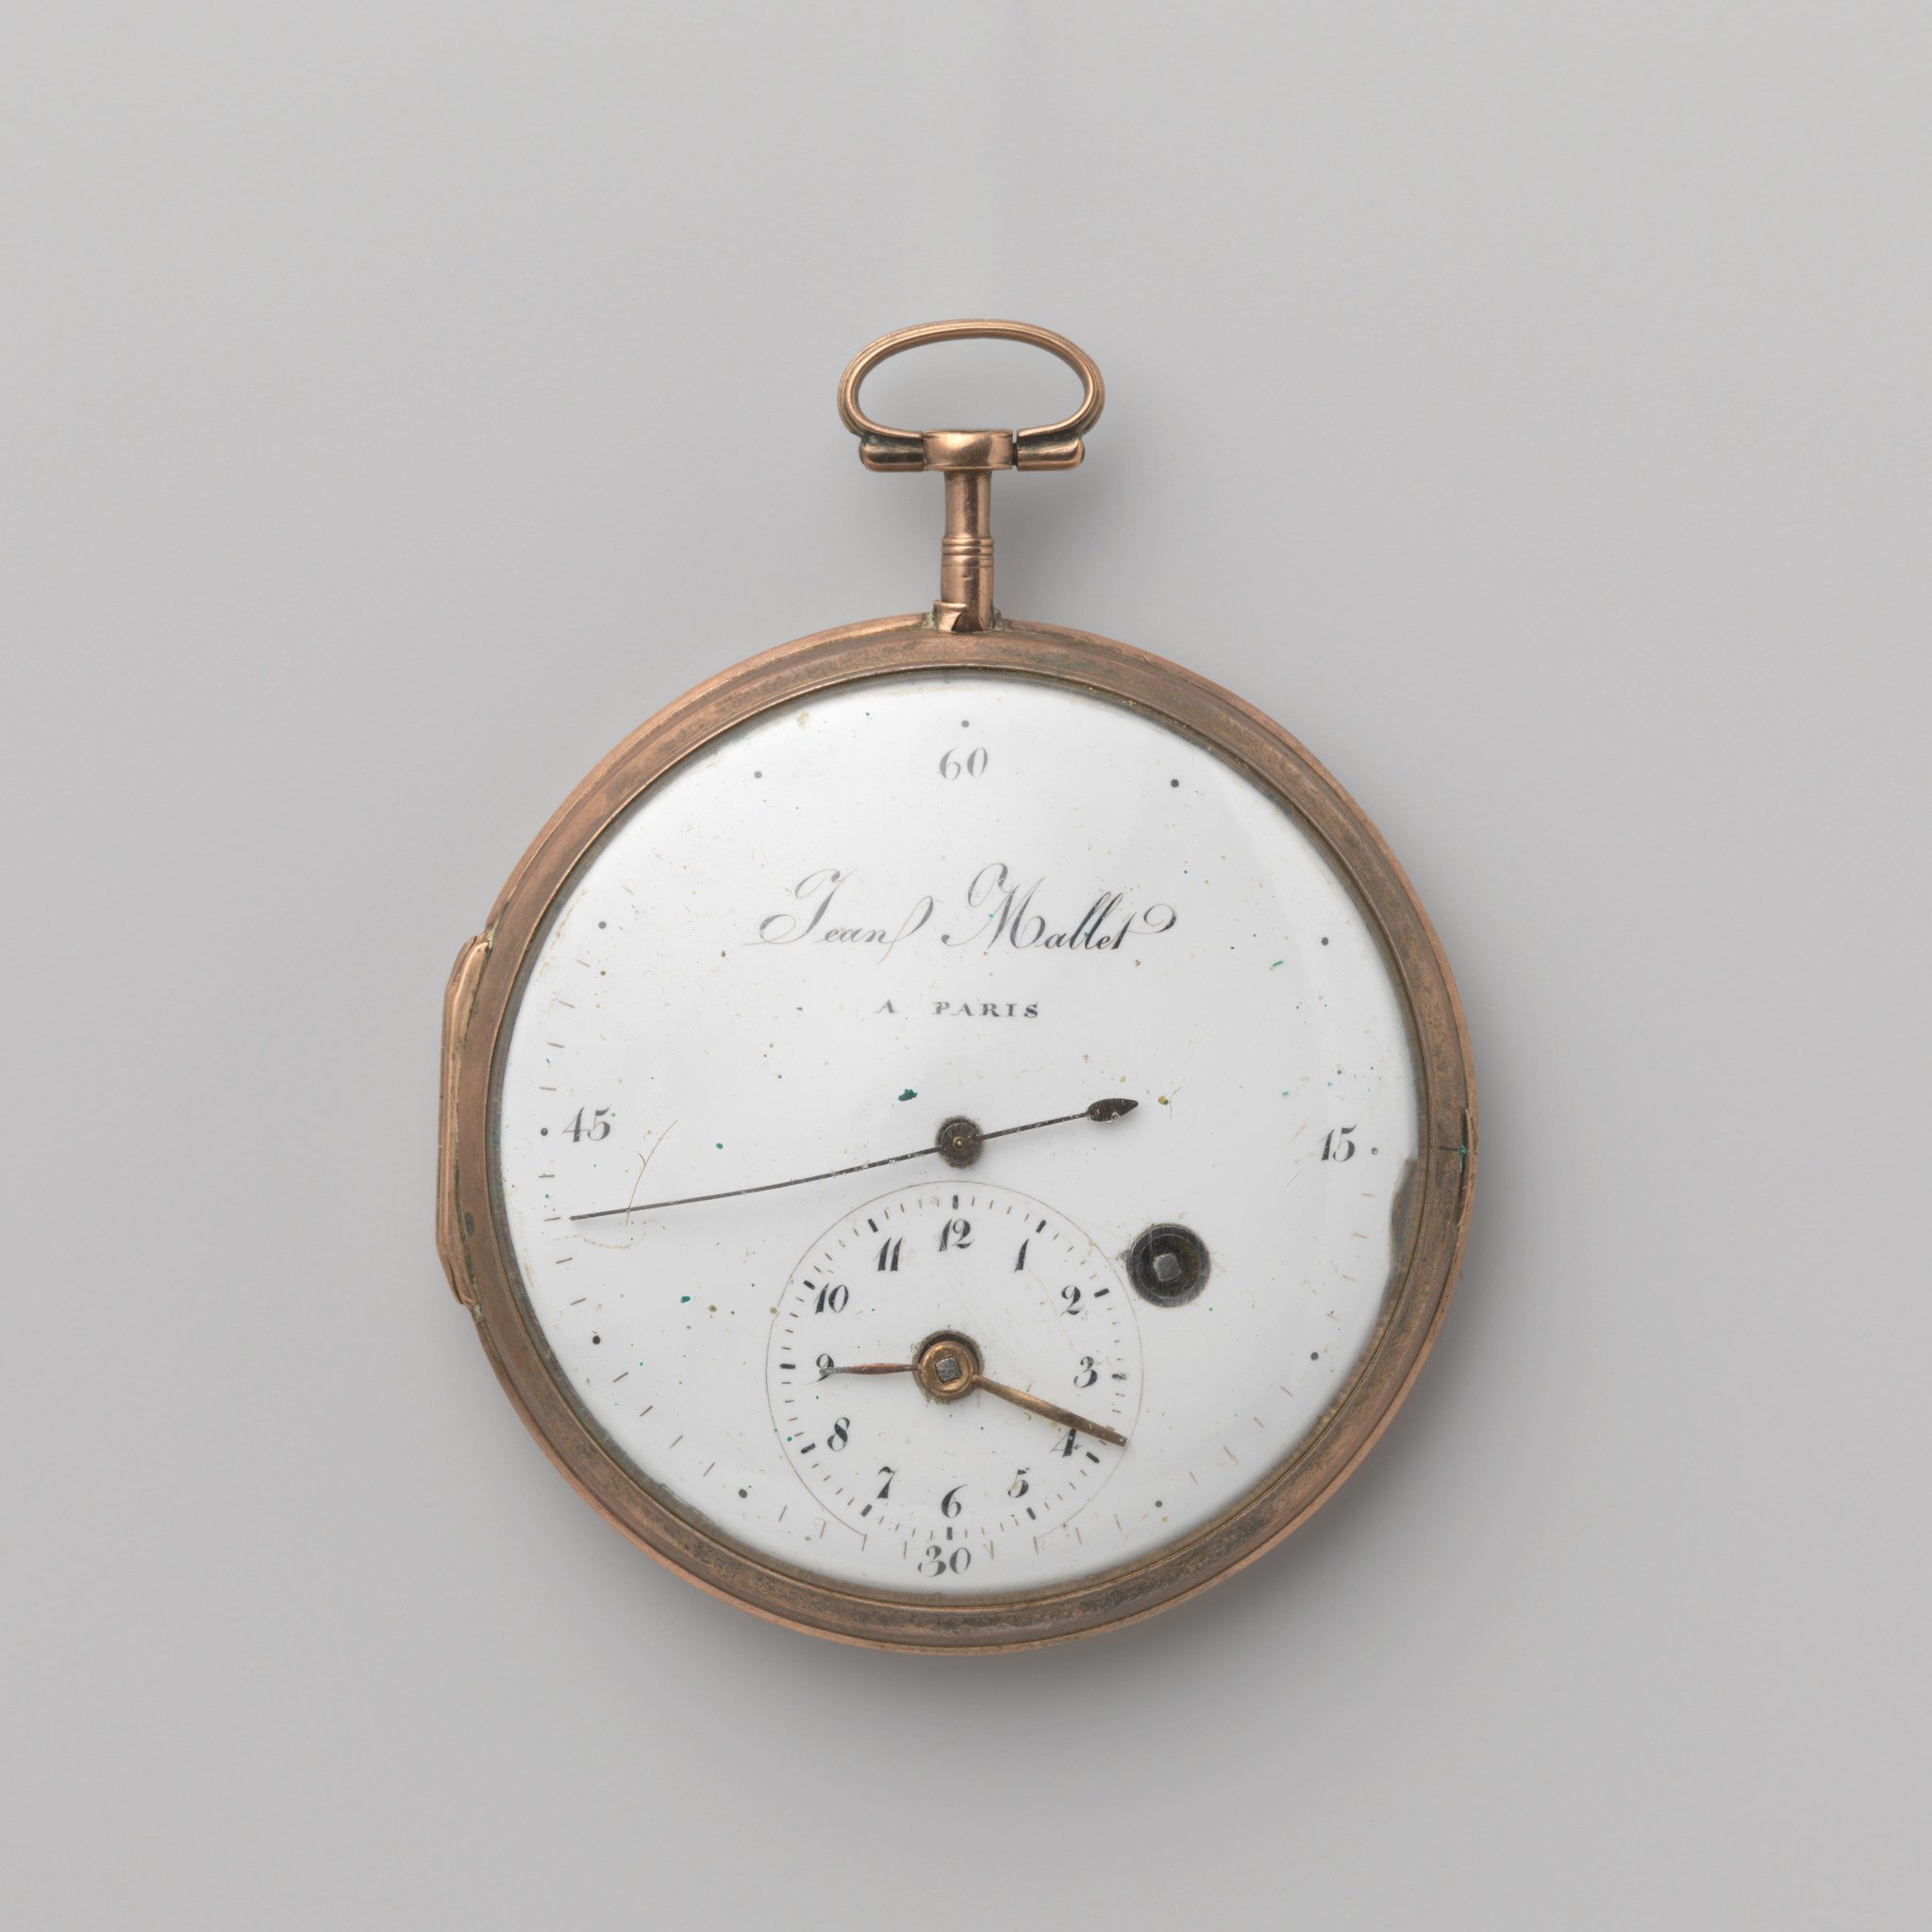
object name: jewellery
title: Horloge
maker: jean mallet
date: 1800-1850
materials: gold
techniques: enameling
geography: paris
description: Herenhorloge van goud met wit geëmailleerde wijzerplaat.